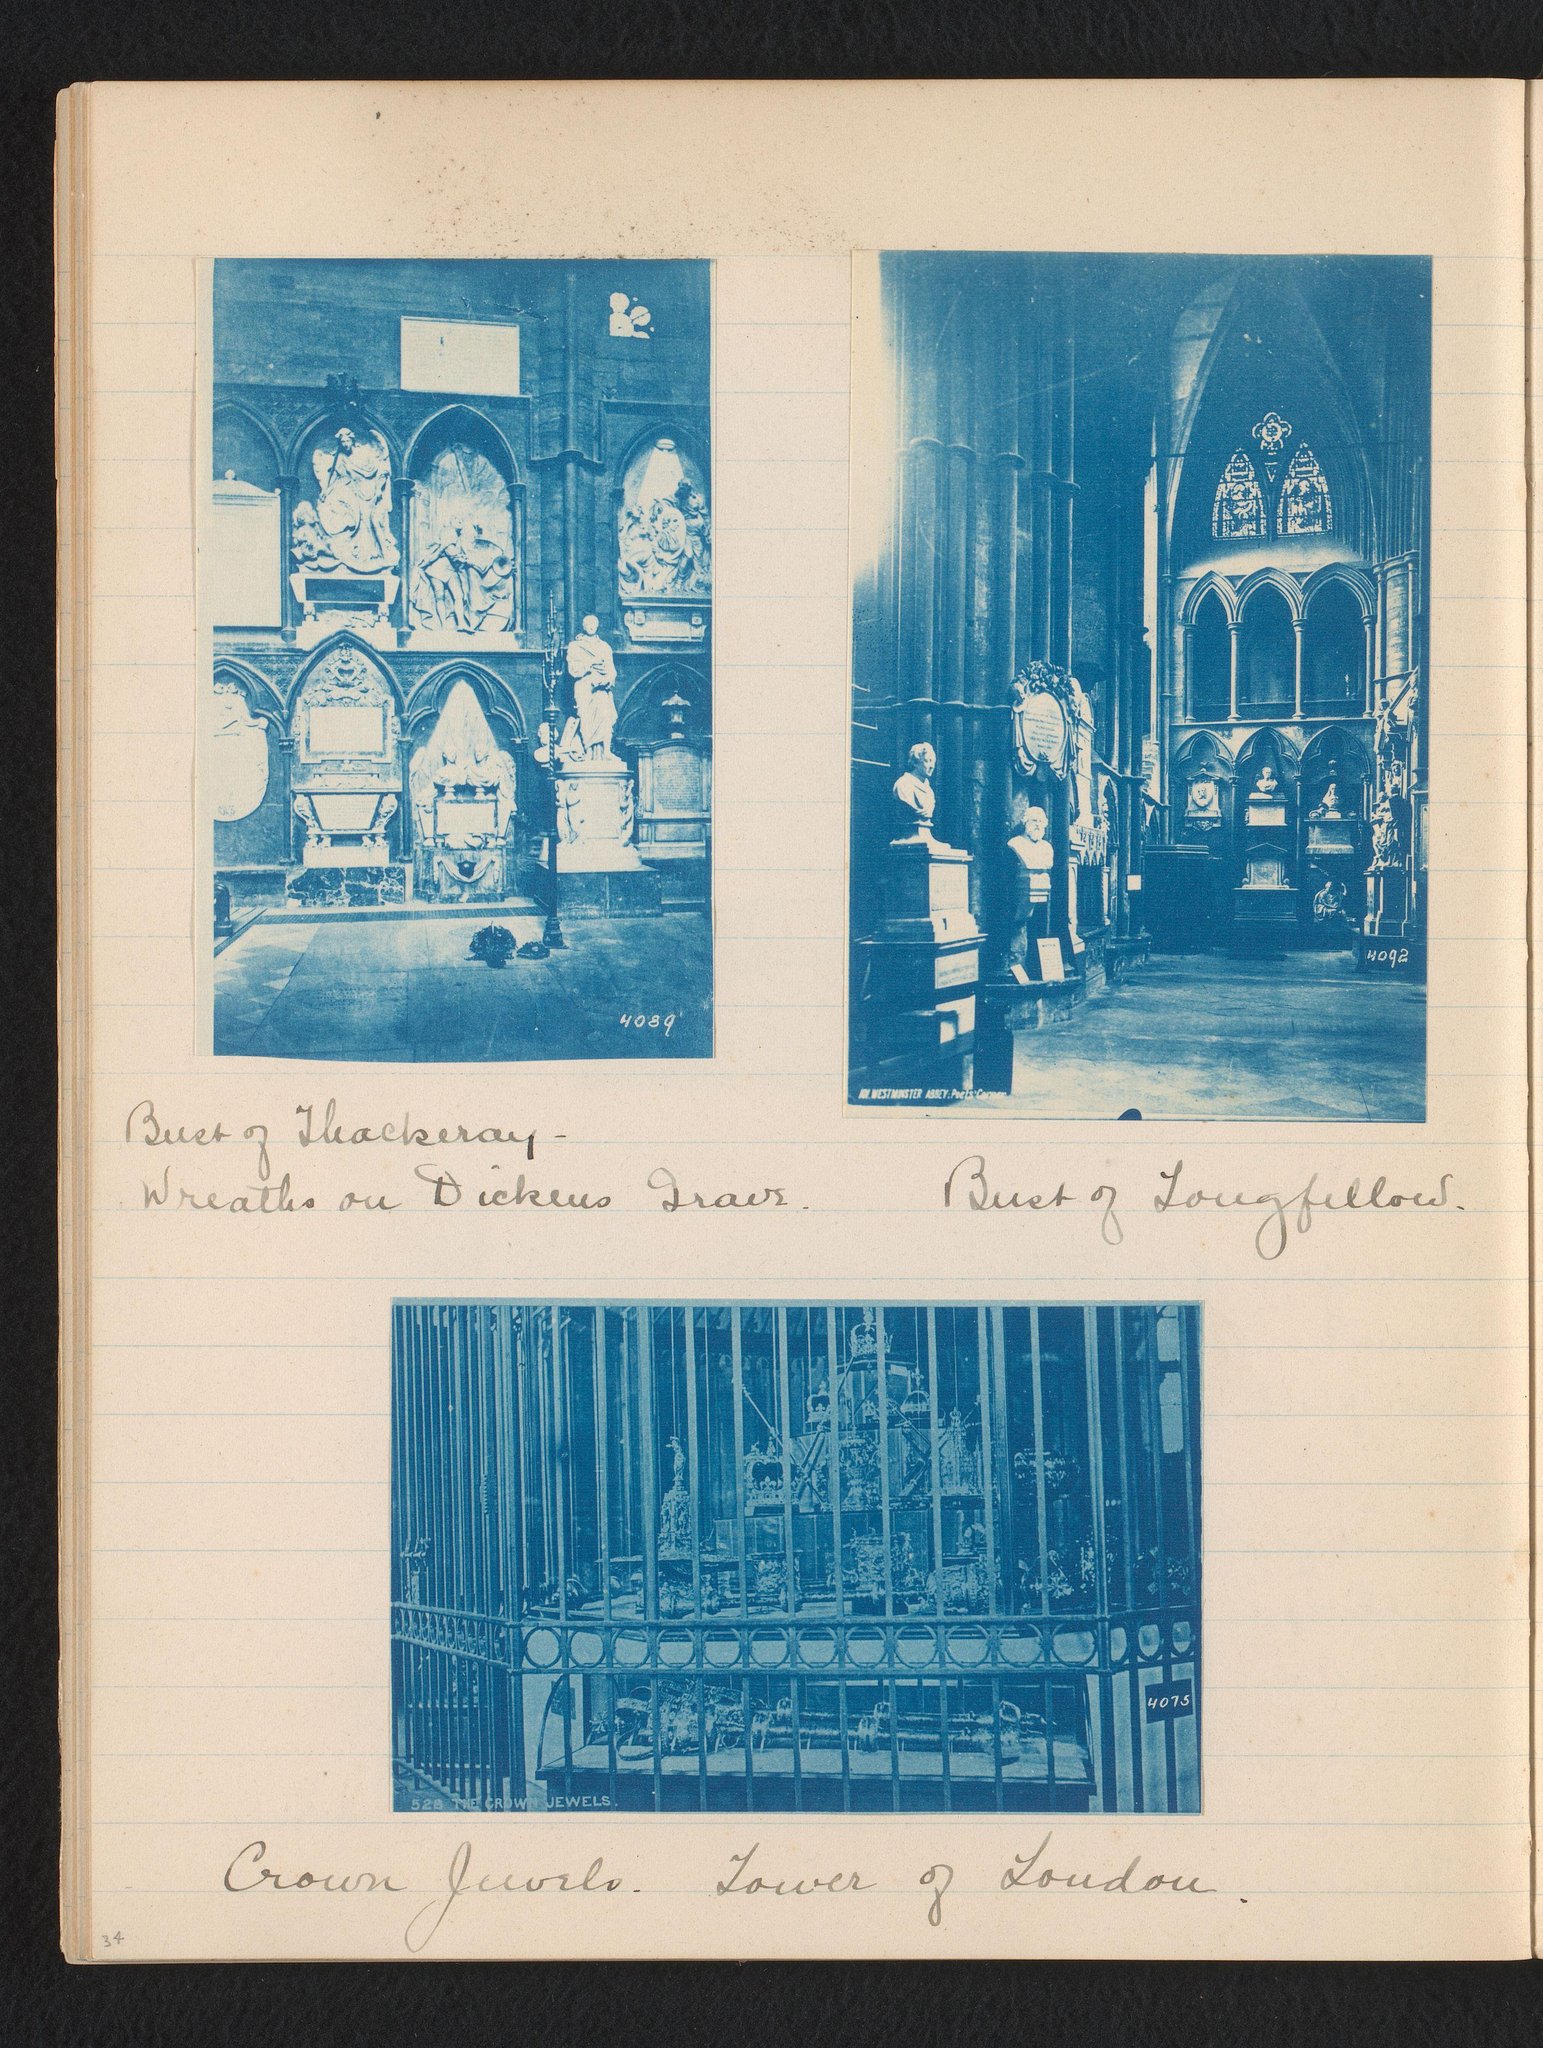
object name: photograph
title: Drie foto's van Poets' Corner in Westminster Abbey en van de kroonjuwelen in de Tower of London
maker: Anonymous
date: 1901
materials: paper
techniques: cyanotype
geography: london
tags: crown (symbol of sovereignty), interior of church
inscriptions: inscription: ‘Bust of Thackeray./ Weaths on Dickens Grave./ Bust of Longfellow./ Crown Jewels. Tower of London’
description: Deze foto's maken deel uit van een album.